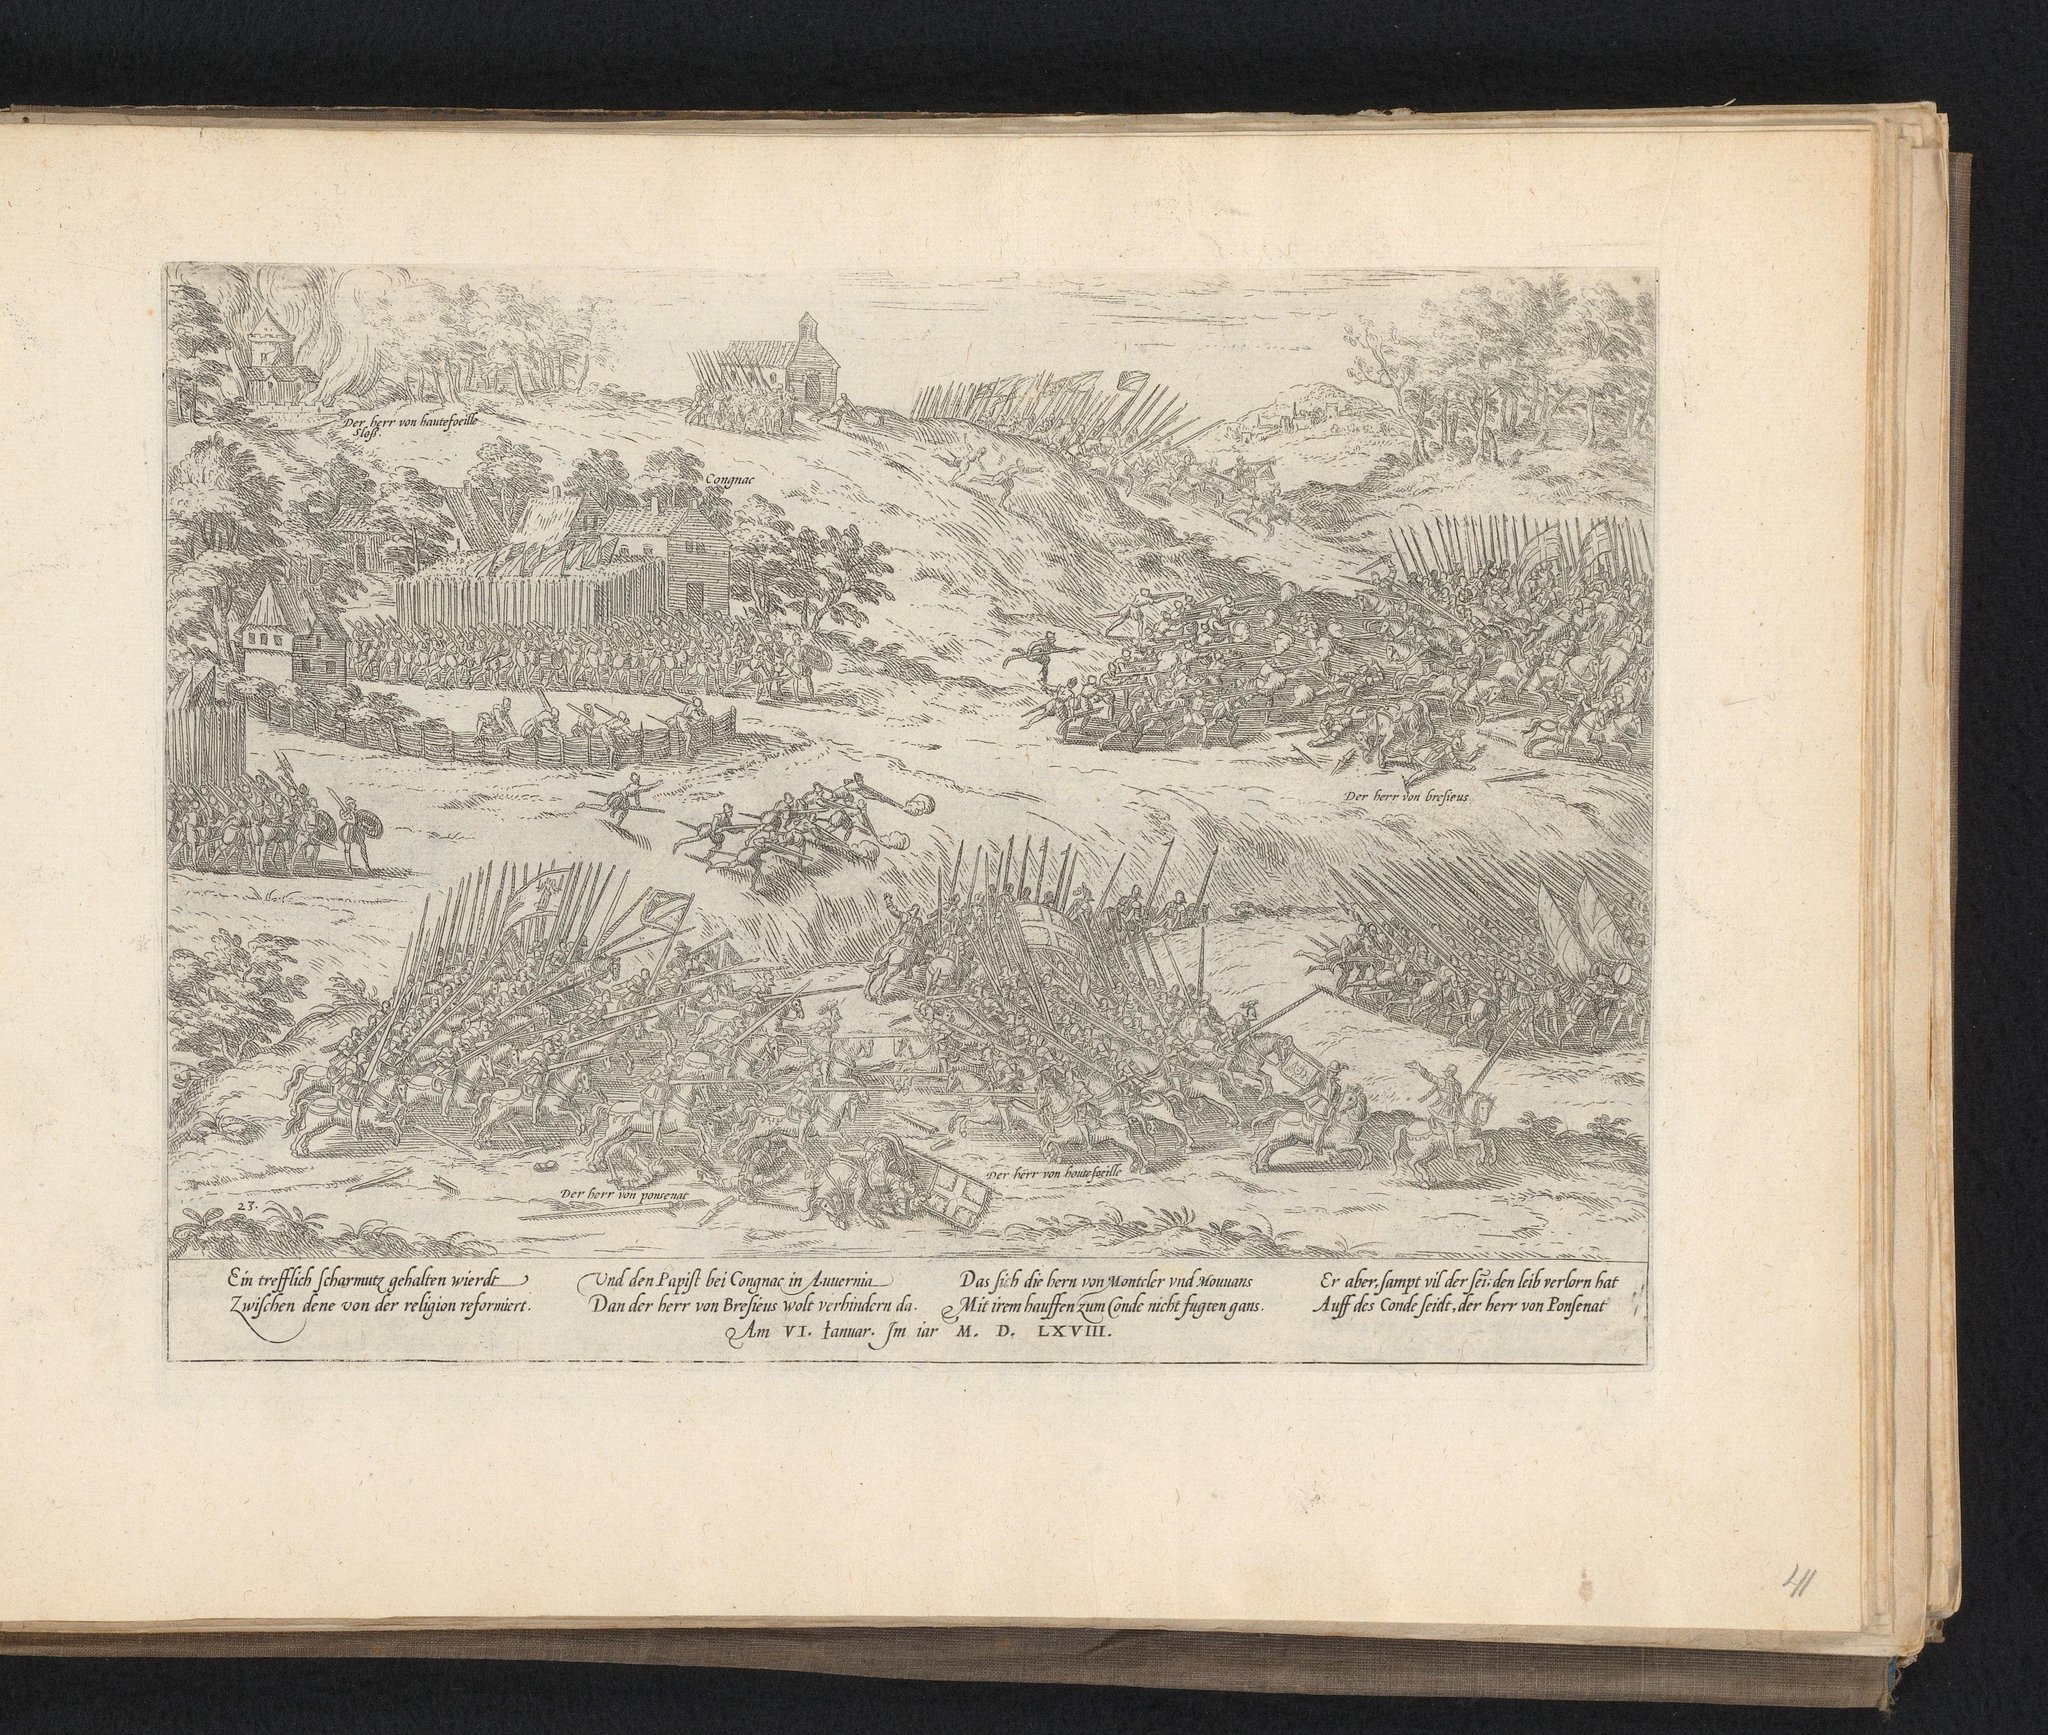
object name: print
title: Slag bij Cognac in de Auvergne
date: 1568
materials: paper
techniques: etching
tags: militant proselytizing: religious war, crusade, etc., battle (+ land forces), the roman catholic church vs. protestantism; (reformation and counter reformation)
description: Prent gebruikt in: Aitsinger, Michael. De Leone Belgico (...). Keulen: s.n., 1588.